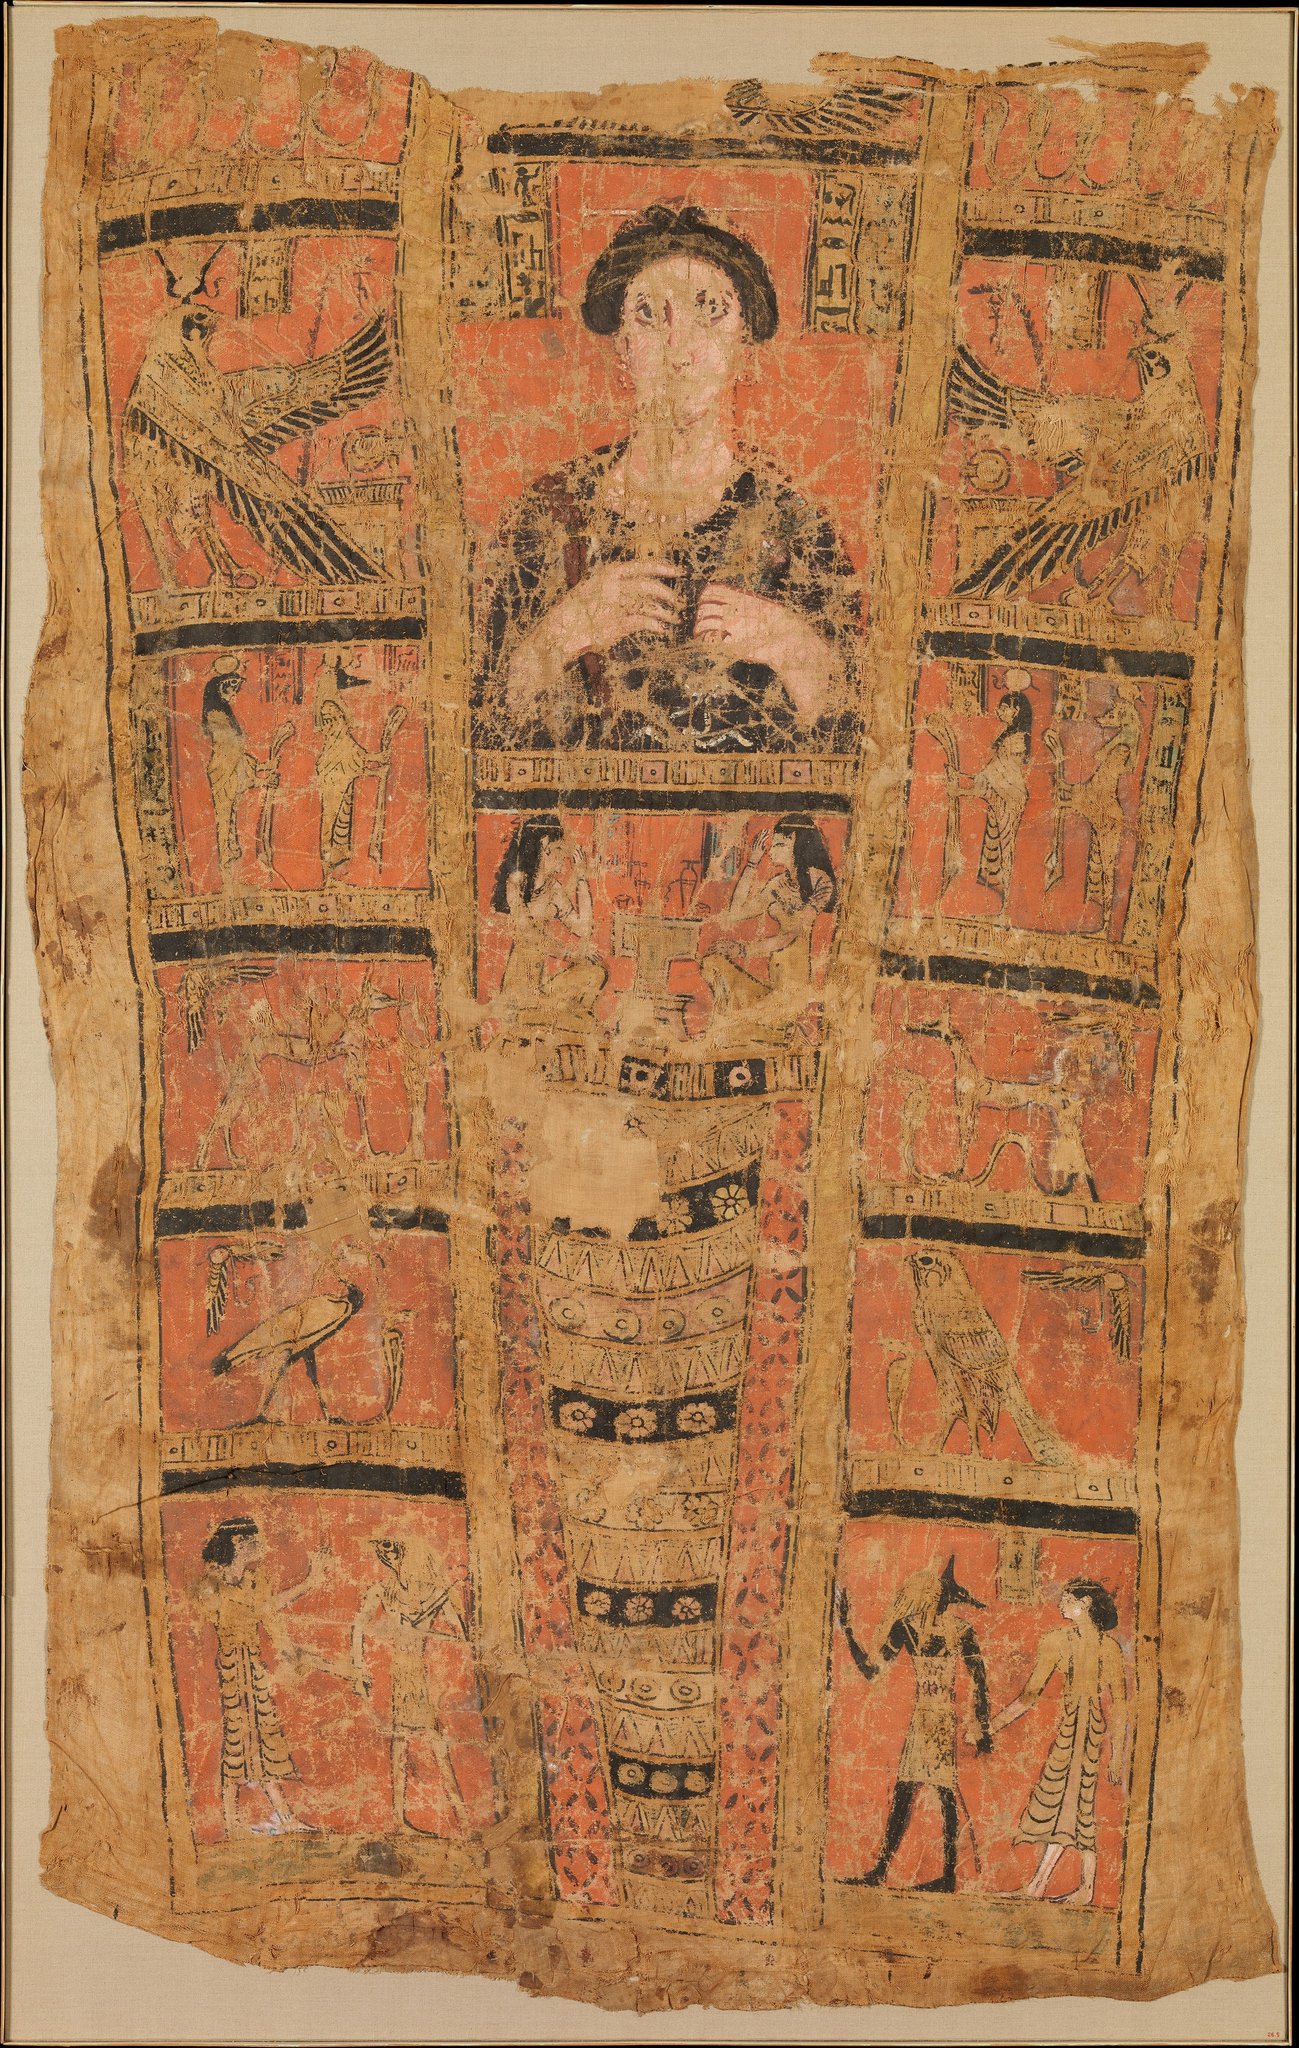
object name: shroud, painted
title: Shroud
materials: linen, paint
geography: egypt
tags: birds,portraits,women,anubis